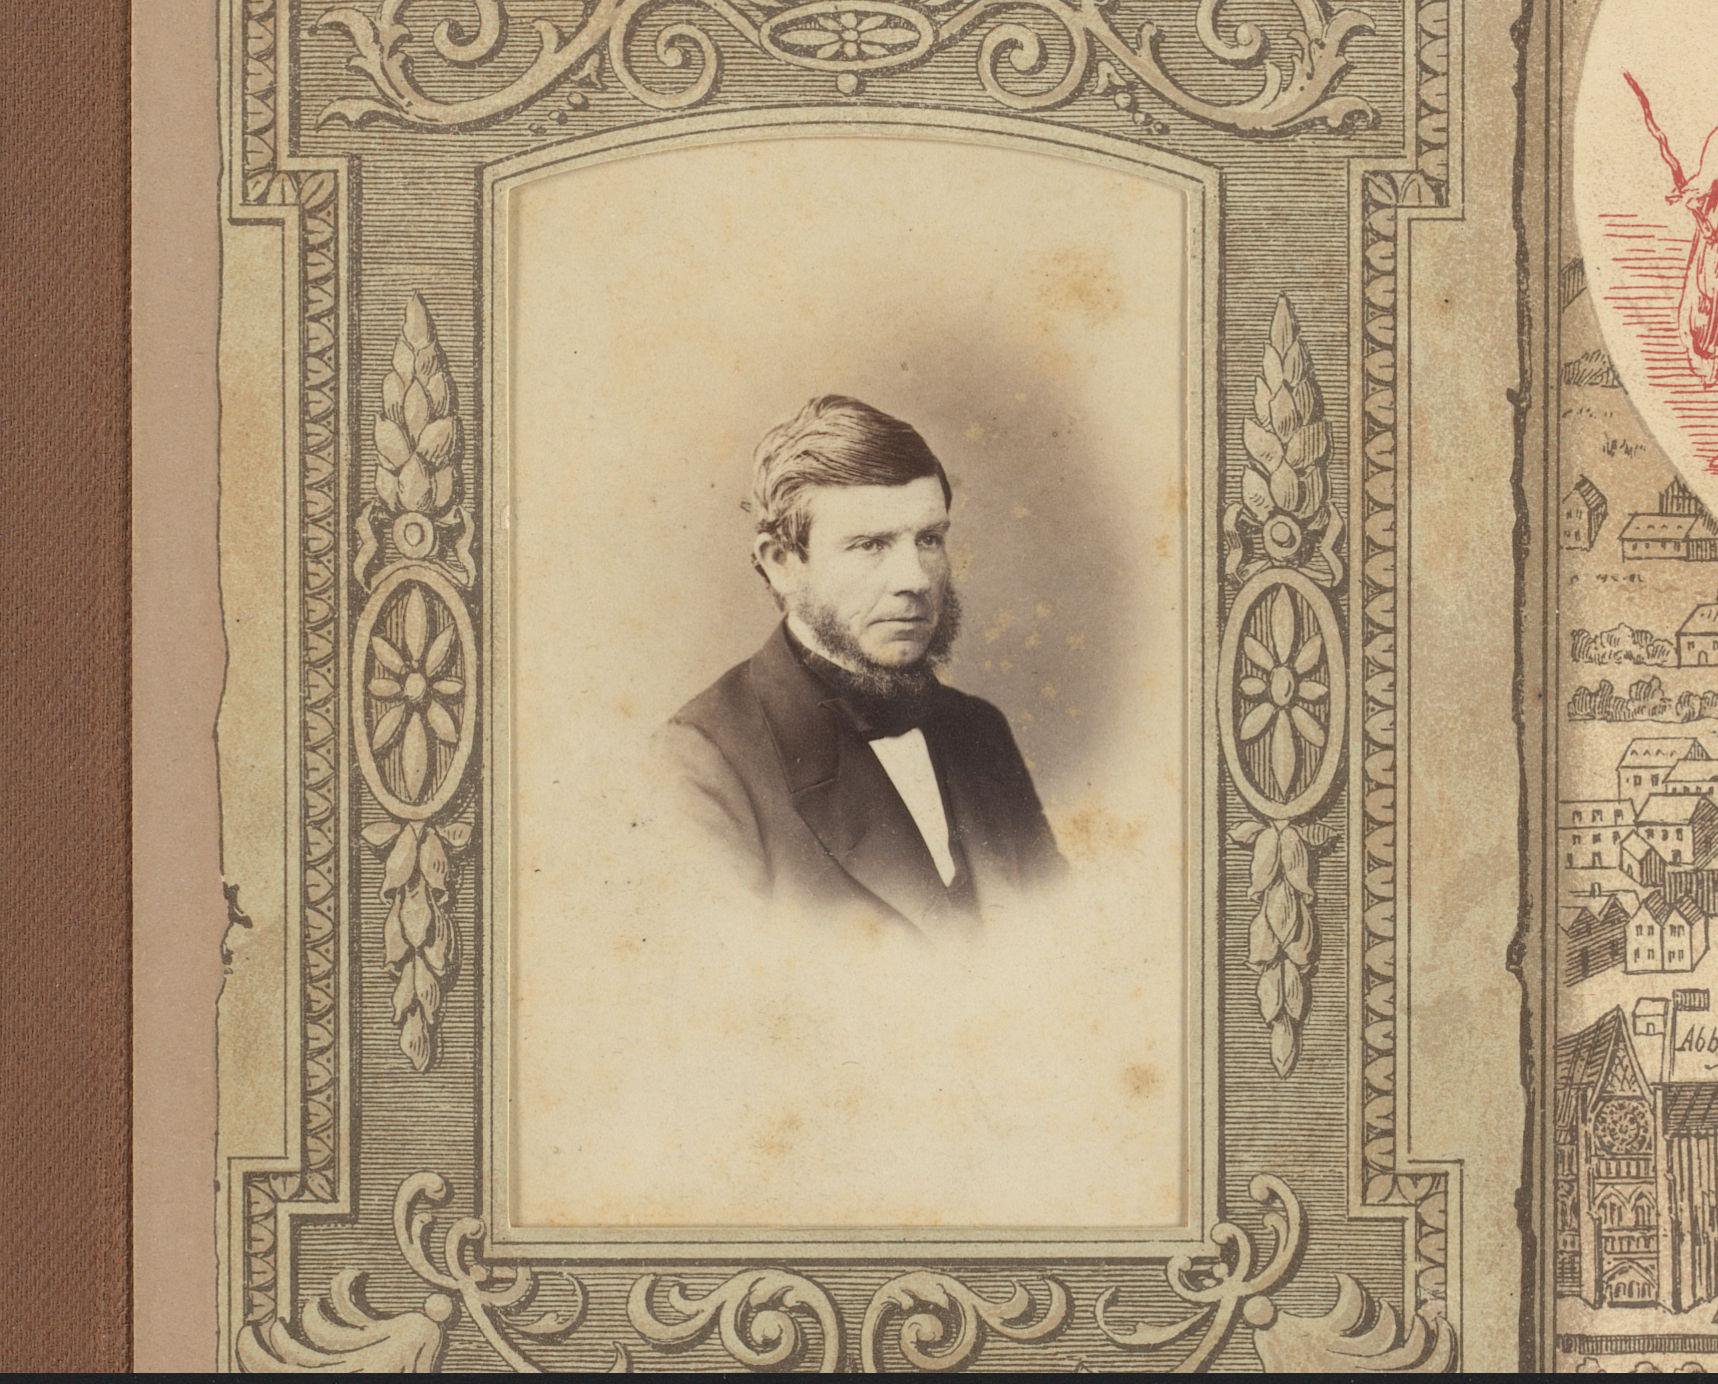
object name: photomechanical print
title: Portret van een man met baard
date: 1861-1864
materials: cardboard, paper, photographic support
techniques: albumen print, planographic printing, printing block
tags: advertising, adult man, historical persons, beard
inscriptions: inscription: ‘Peckham Photographic Studio/ Mr. J. Wellings/ 9, Coborn Terrace/ Rye Lane/ Peckham’, annotation: ‘[...]’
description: Op het albumblad, rondom het passe-partout, reproducties van prenten van onder meer een uitzicht op London Bridge en een landkaart van Whitehall en Westminster. Deze foto maakt deel uit van een album.